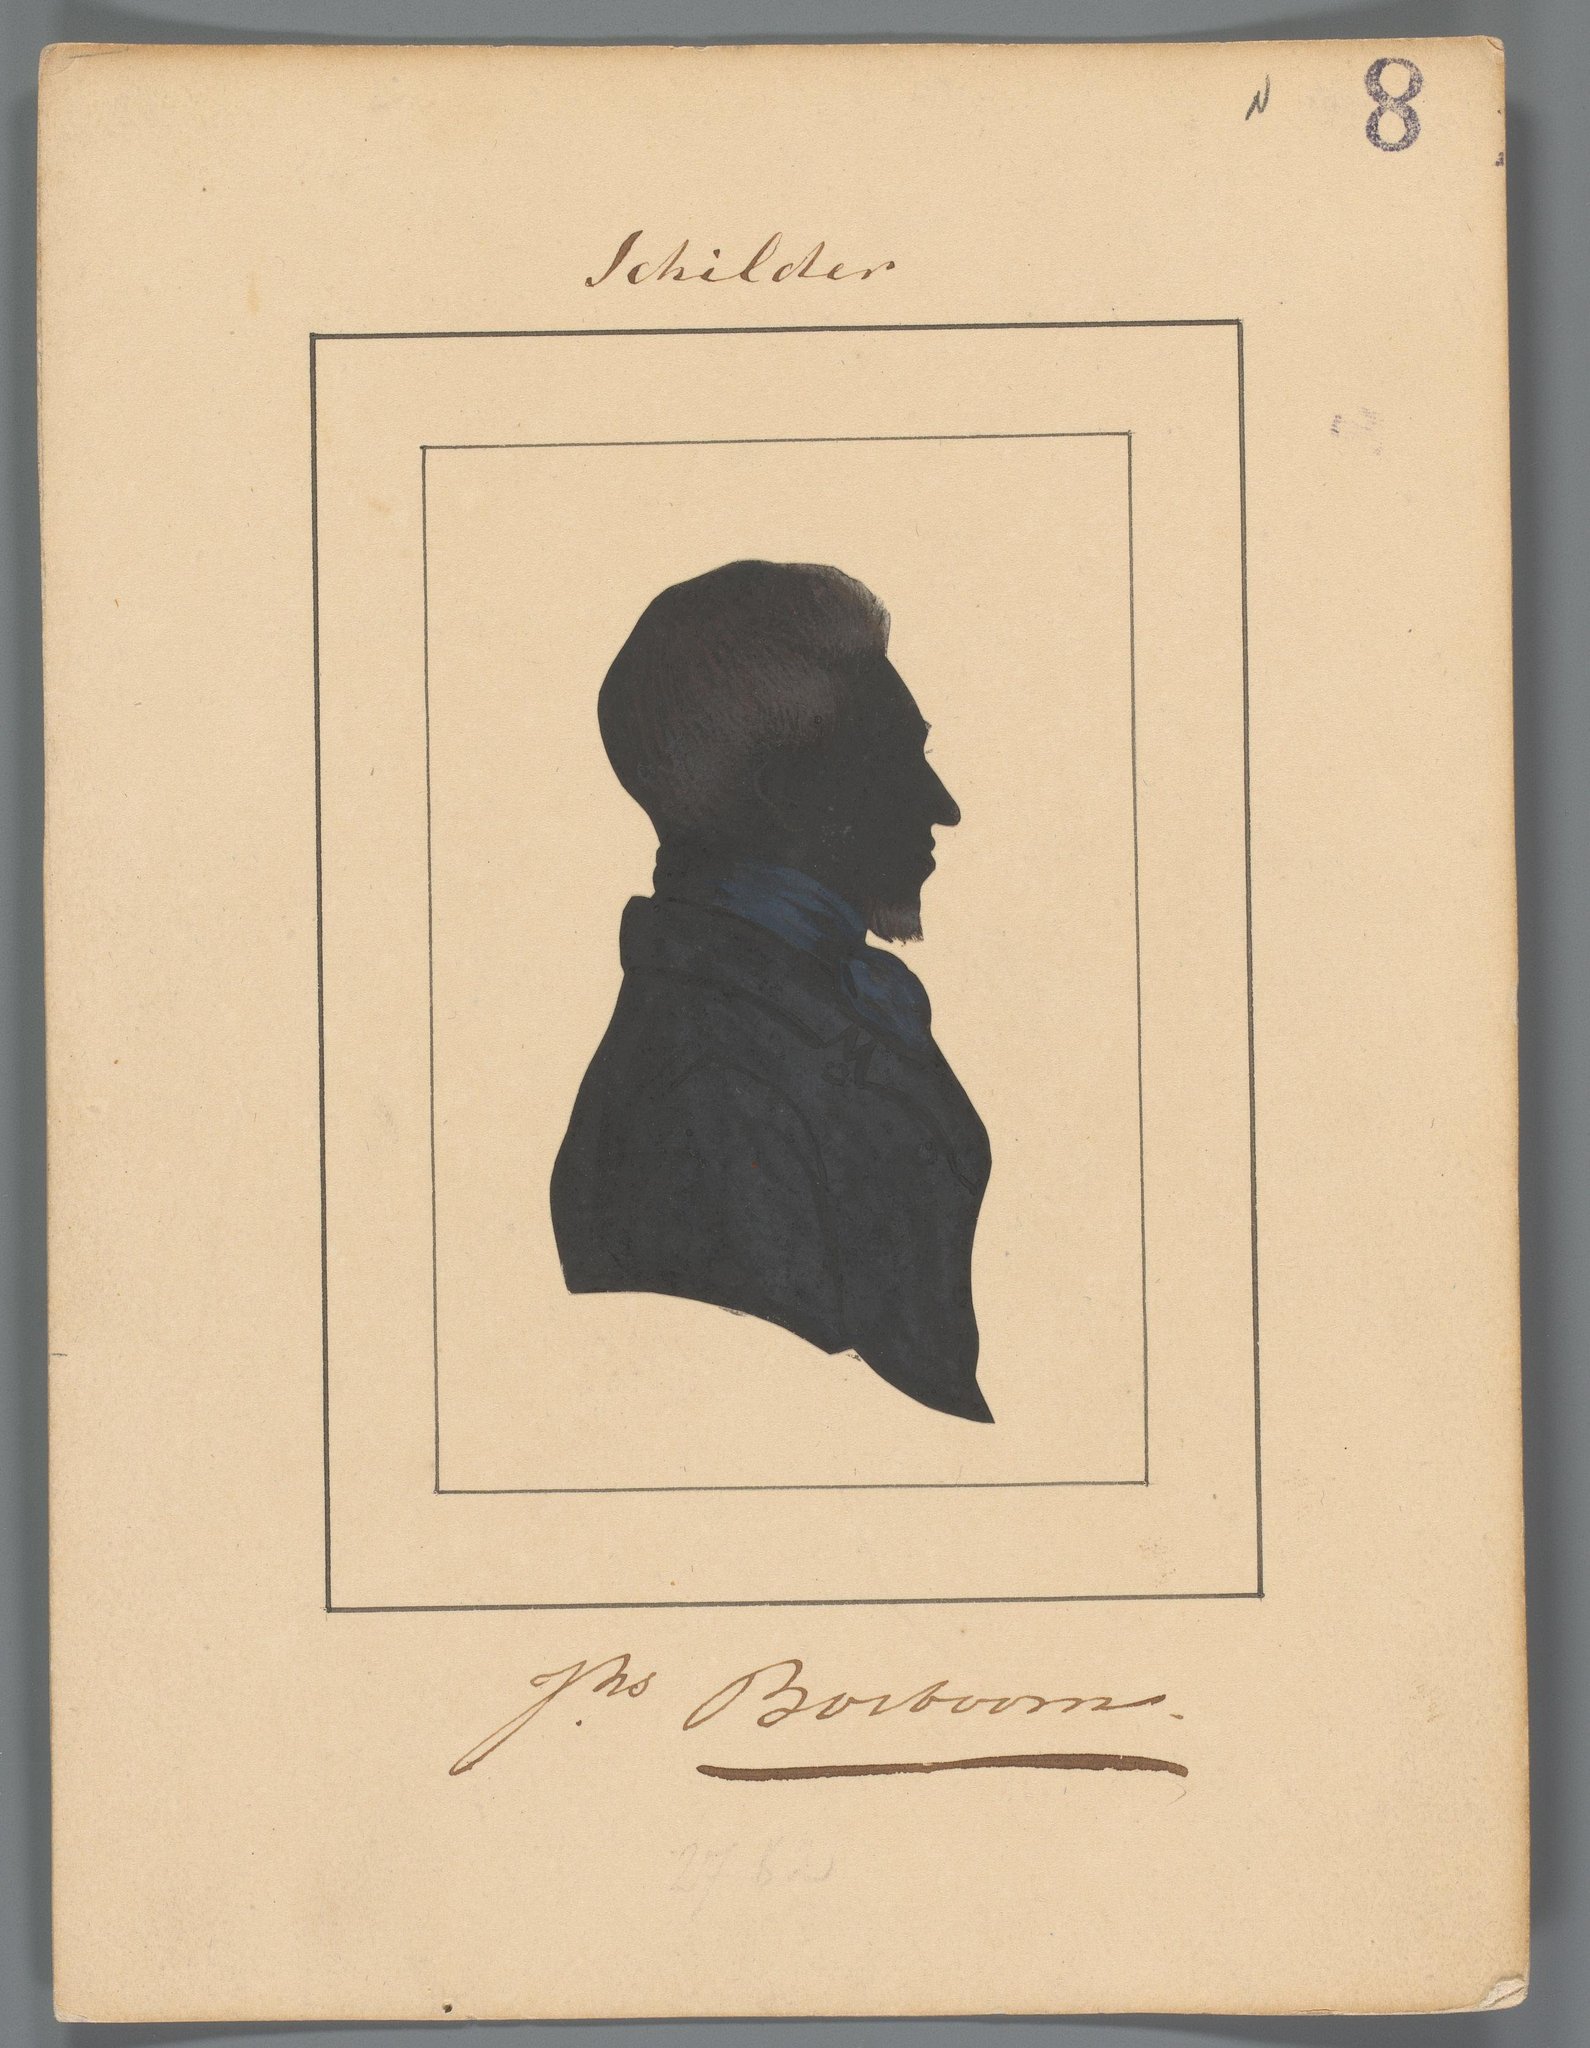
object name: cut paper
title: Silhouetportret van Johannes Bosboom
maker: elisabeth alida haanen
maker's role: draughtsman, print maker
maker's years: 1809-1845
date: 1819-1845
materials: ink, paint, paper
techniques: brush, snipping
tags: the hague, painter, johannes bosboom, historical persons, portrait, self-portrait of painter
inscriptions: number: ‘13943’, number: ‘8’, inscription: ‘Jhs. Bosboom’, collector's mark: ‘Ex-libris van Beresteyn’, inscription: ‘Schilder’, inscription: ‘D. 1343’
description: Met onder het portret de handtekening van de geportretteerde.